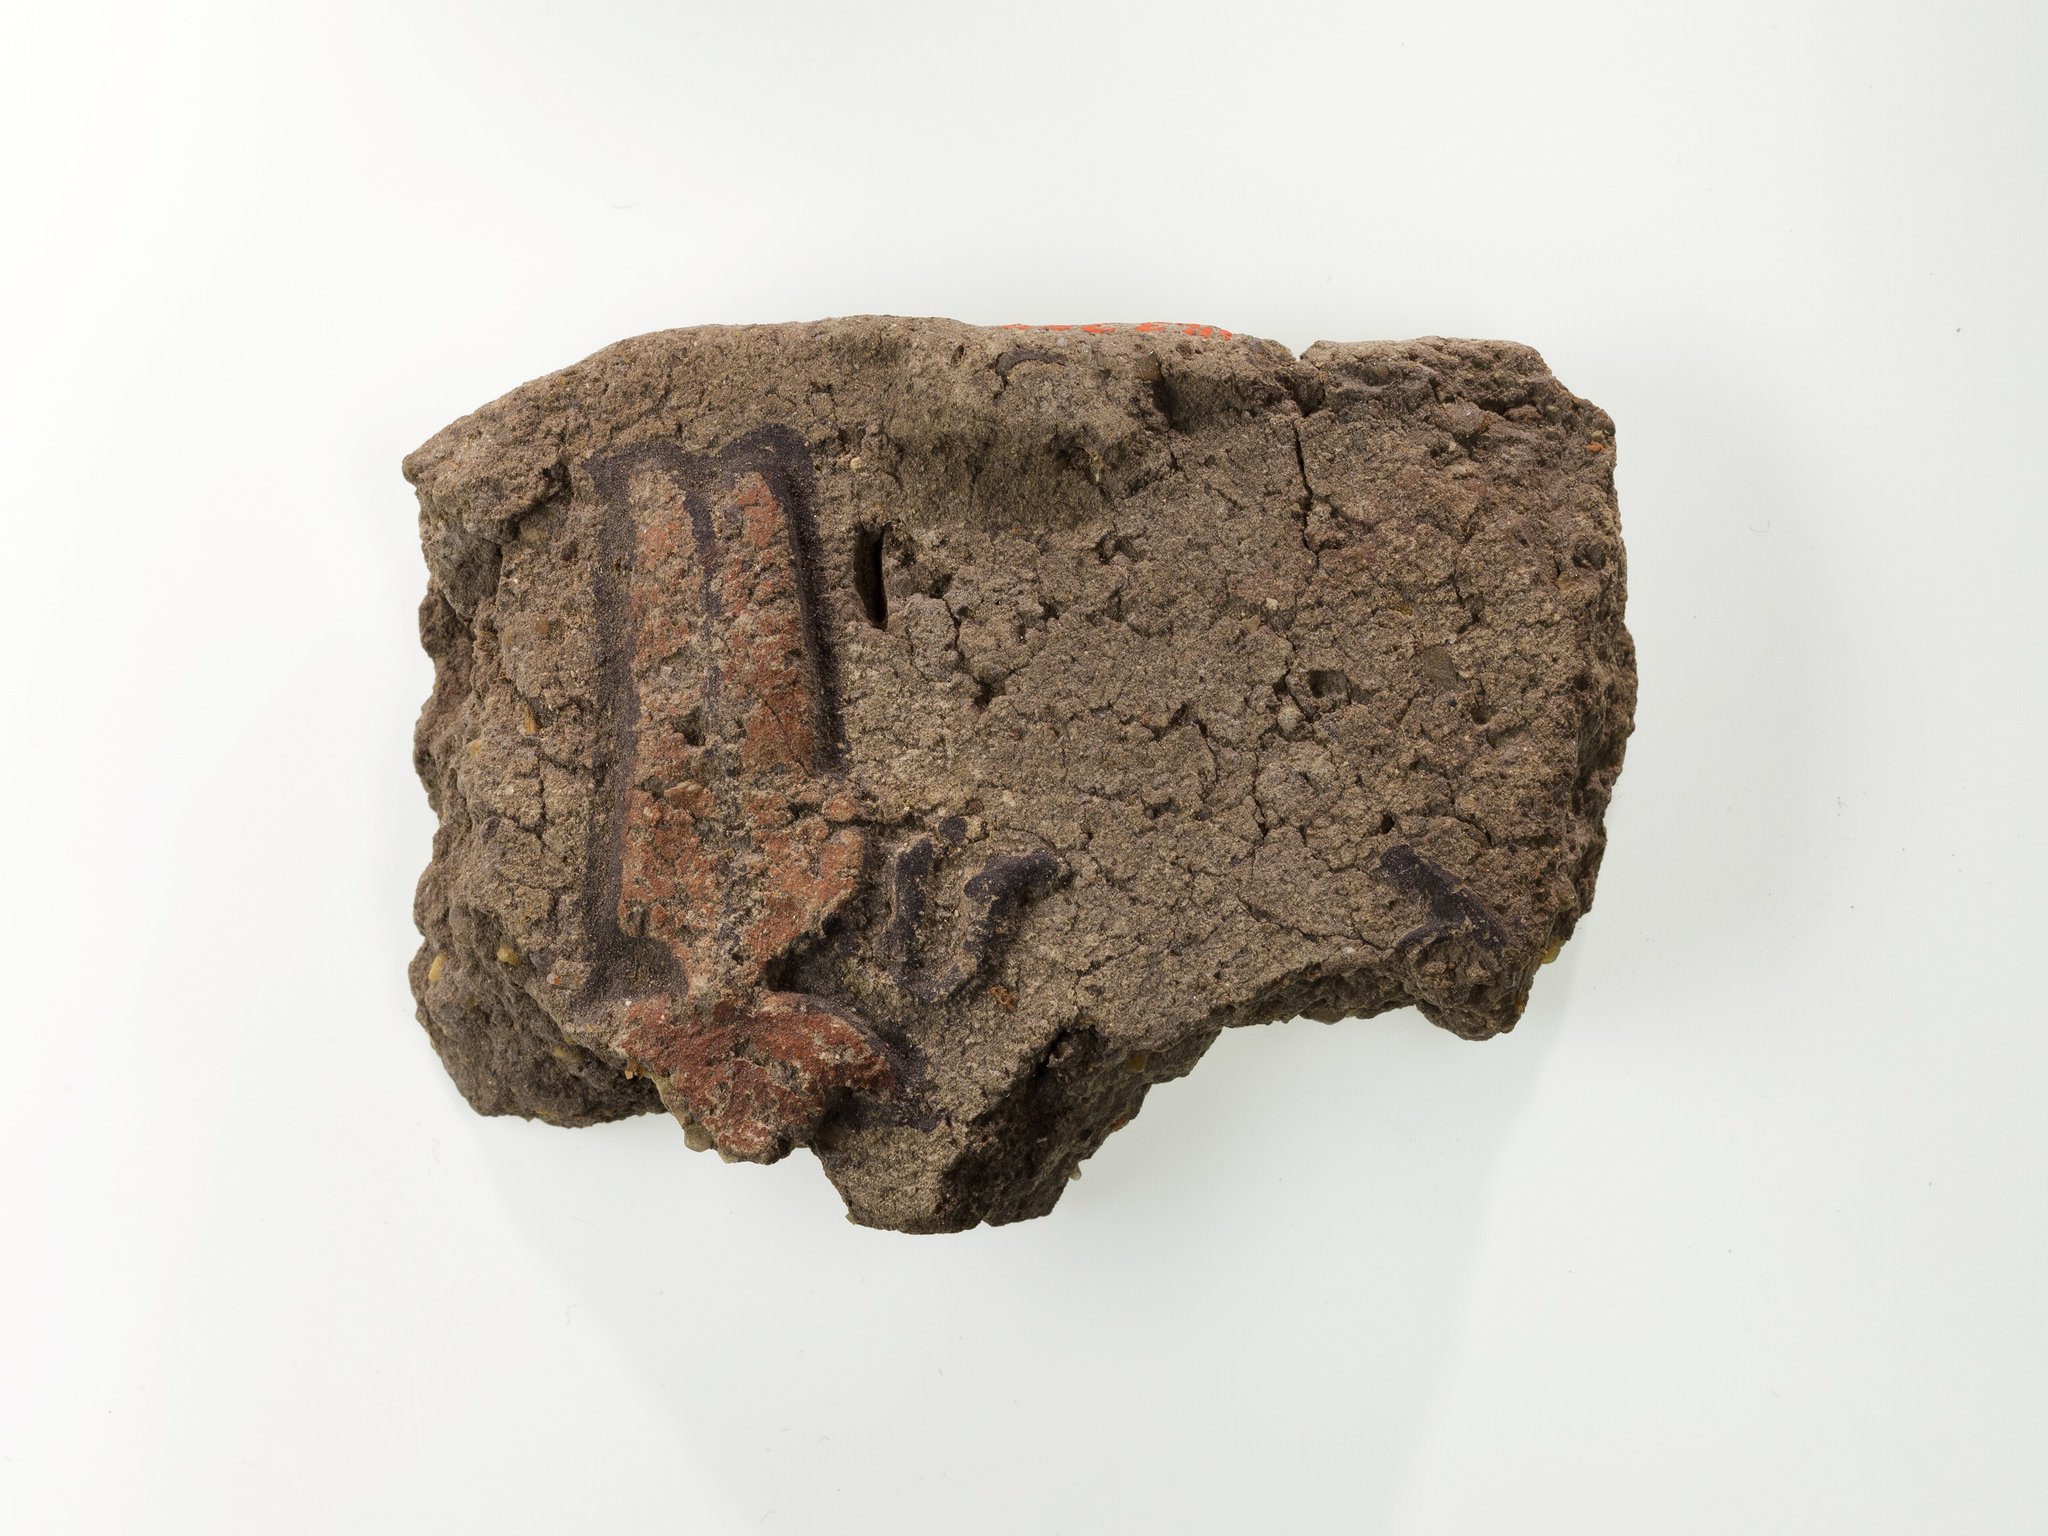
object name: vessel fragment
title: Part of ceremonial object?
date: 1802-1640 BCE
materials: mud